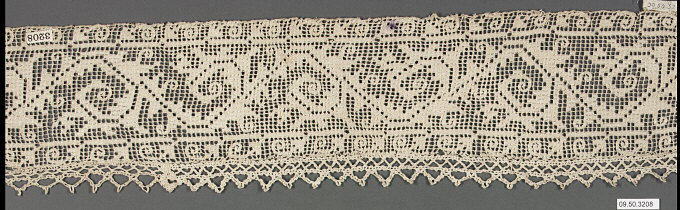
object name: border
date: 1701-1800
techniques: lace, embroidery